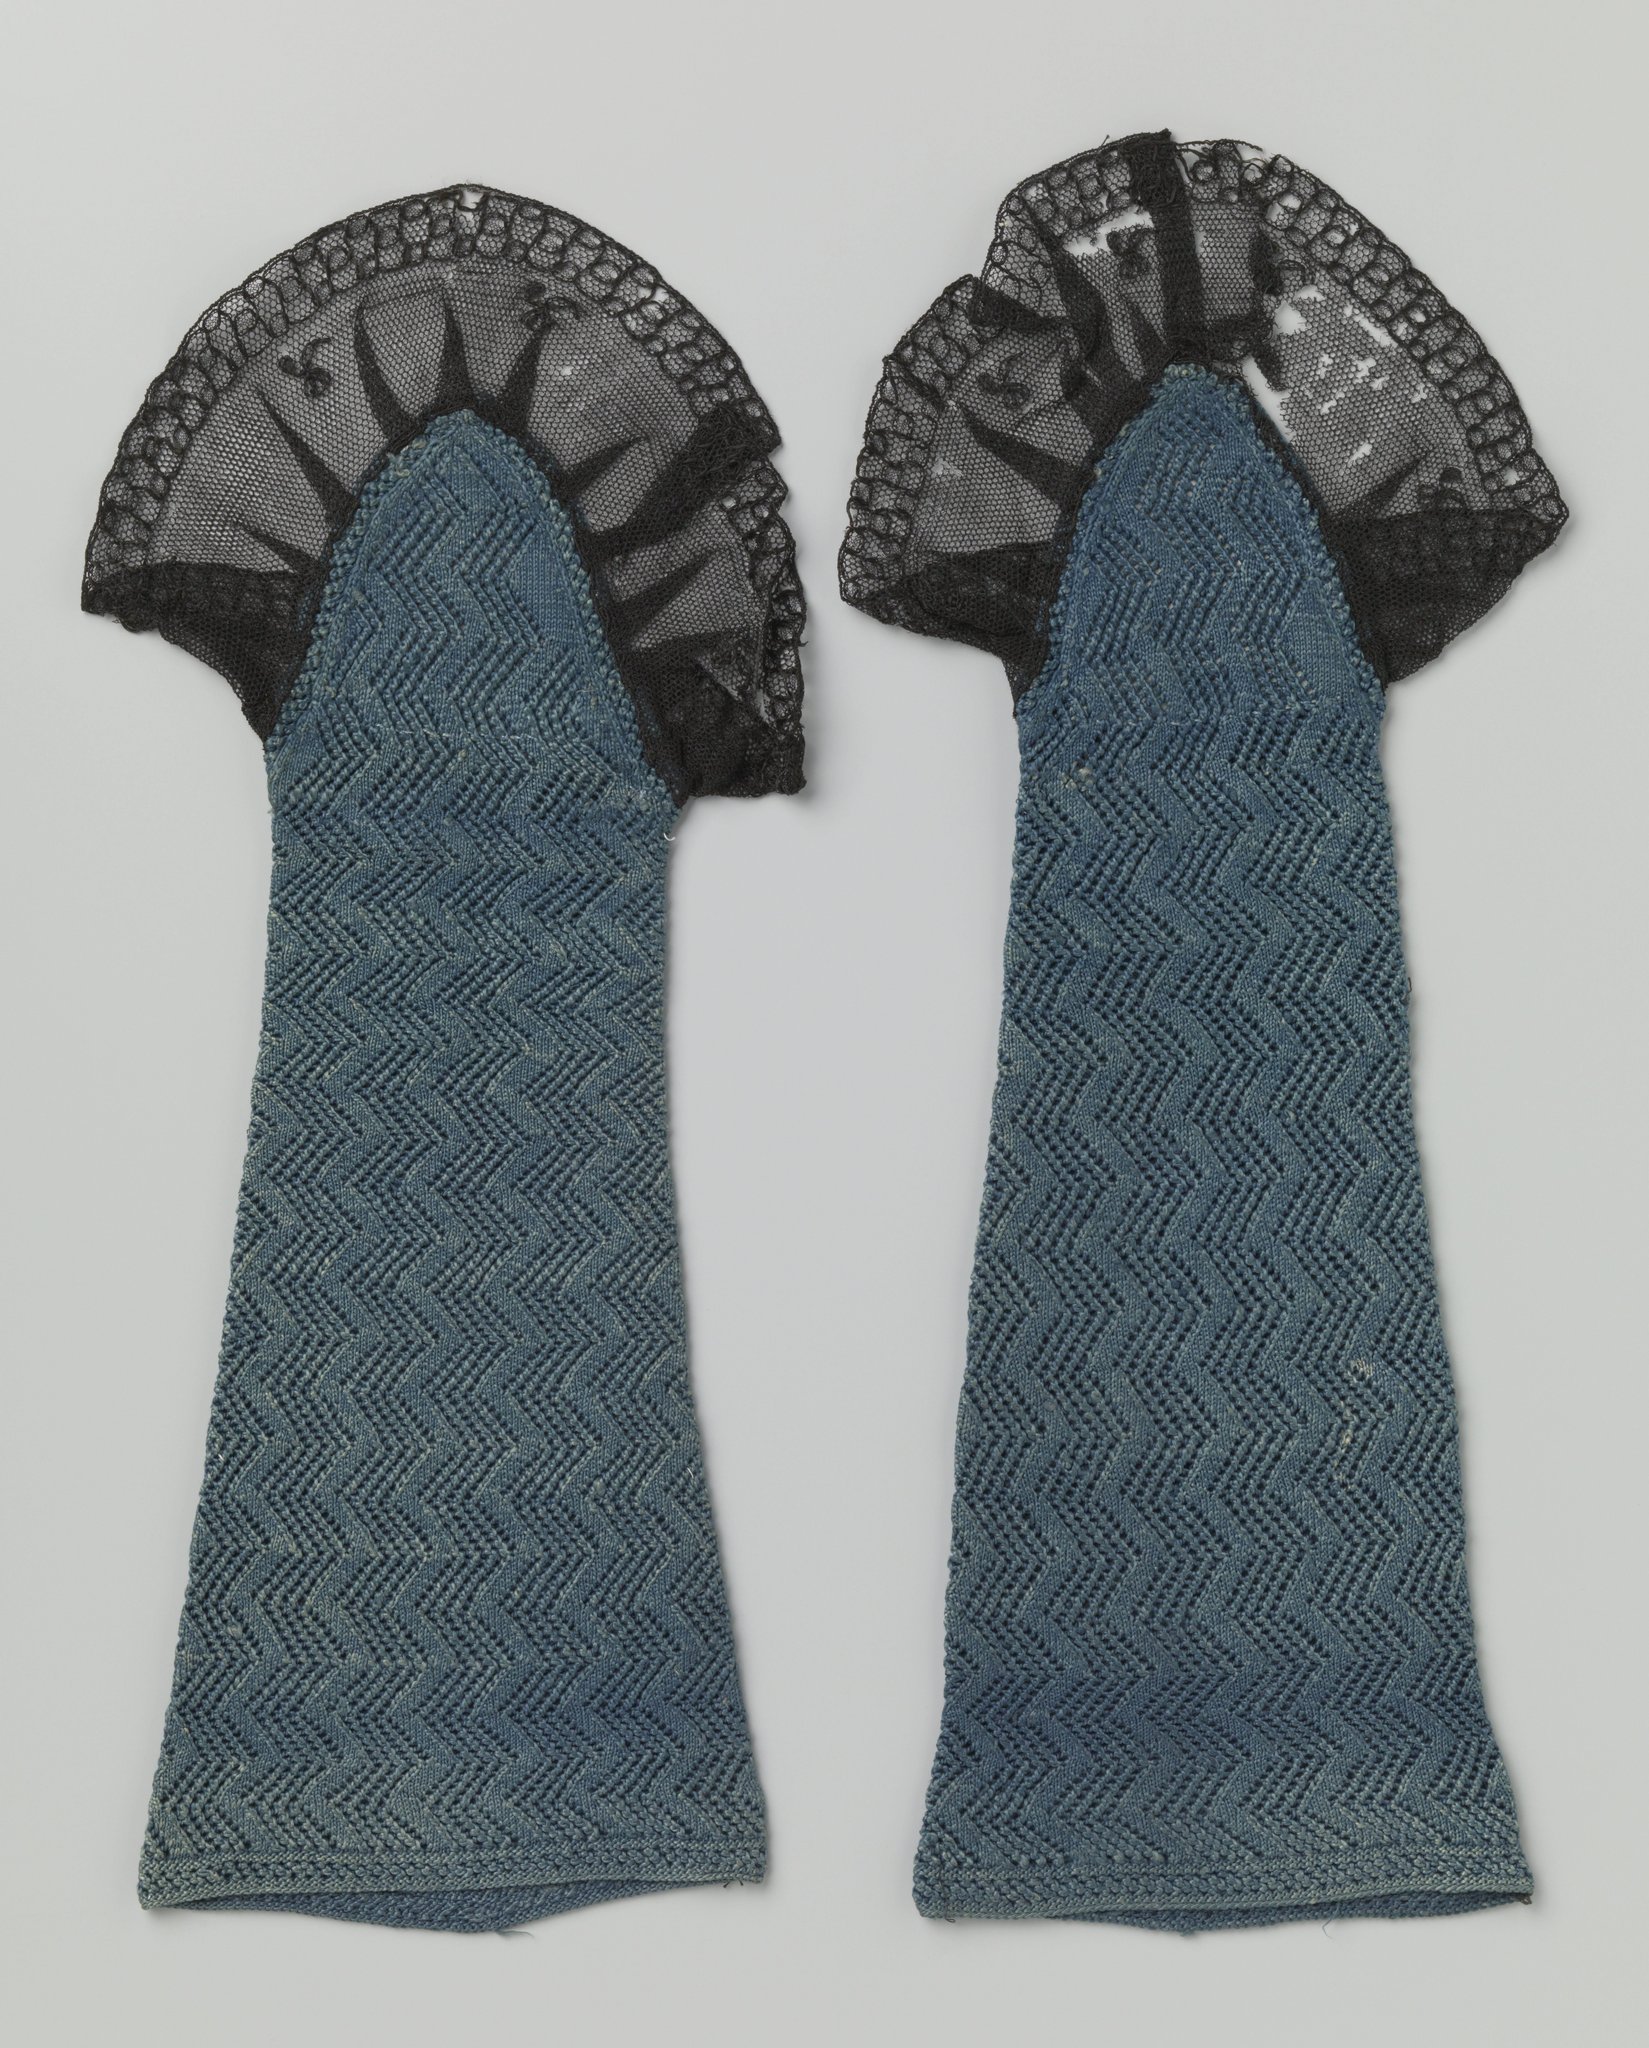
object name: mitt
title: Mitaine van blauwe zijde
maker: Anonymous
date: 1800-1825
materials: silk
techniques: knitting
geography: zaanstreek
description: Paar blauwe gebreide mitaines met opengewerkte zig-zag strepen. Afgezet met doorgestopte, zwarte tulle.